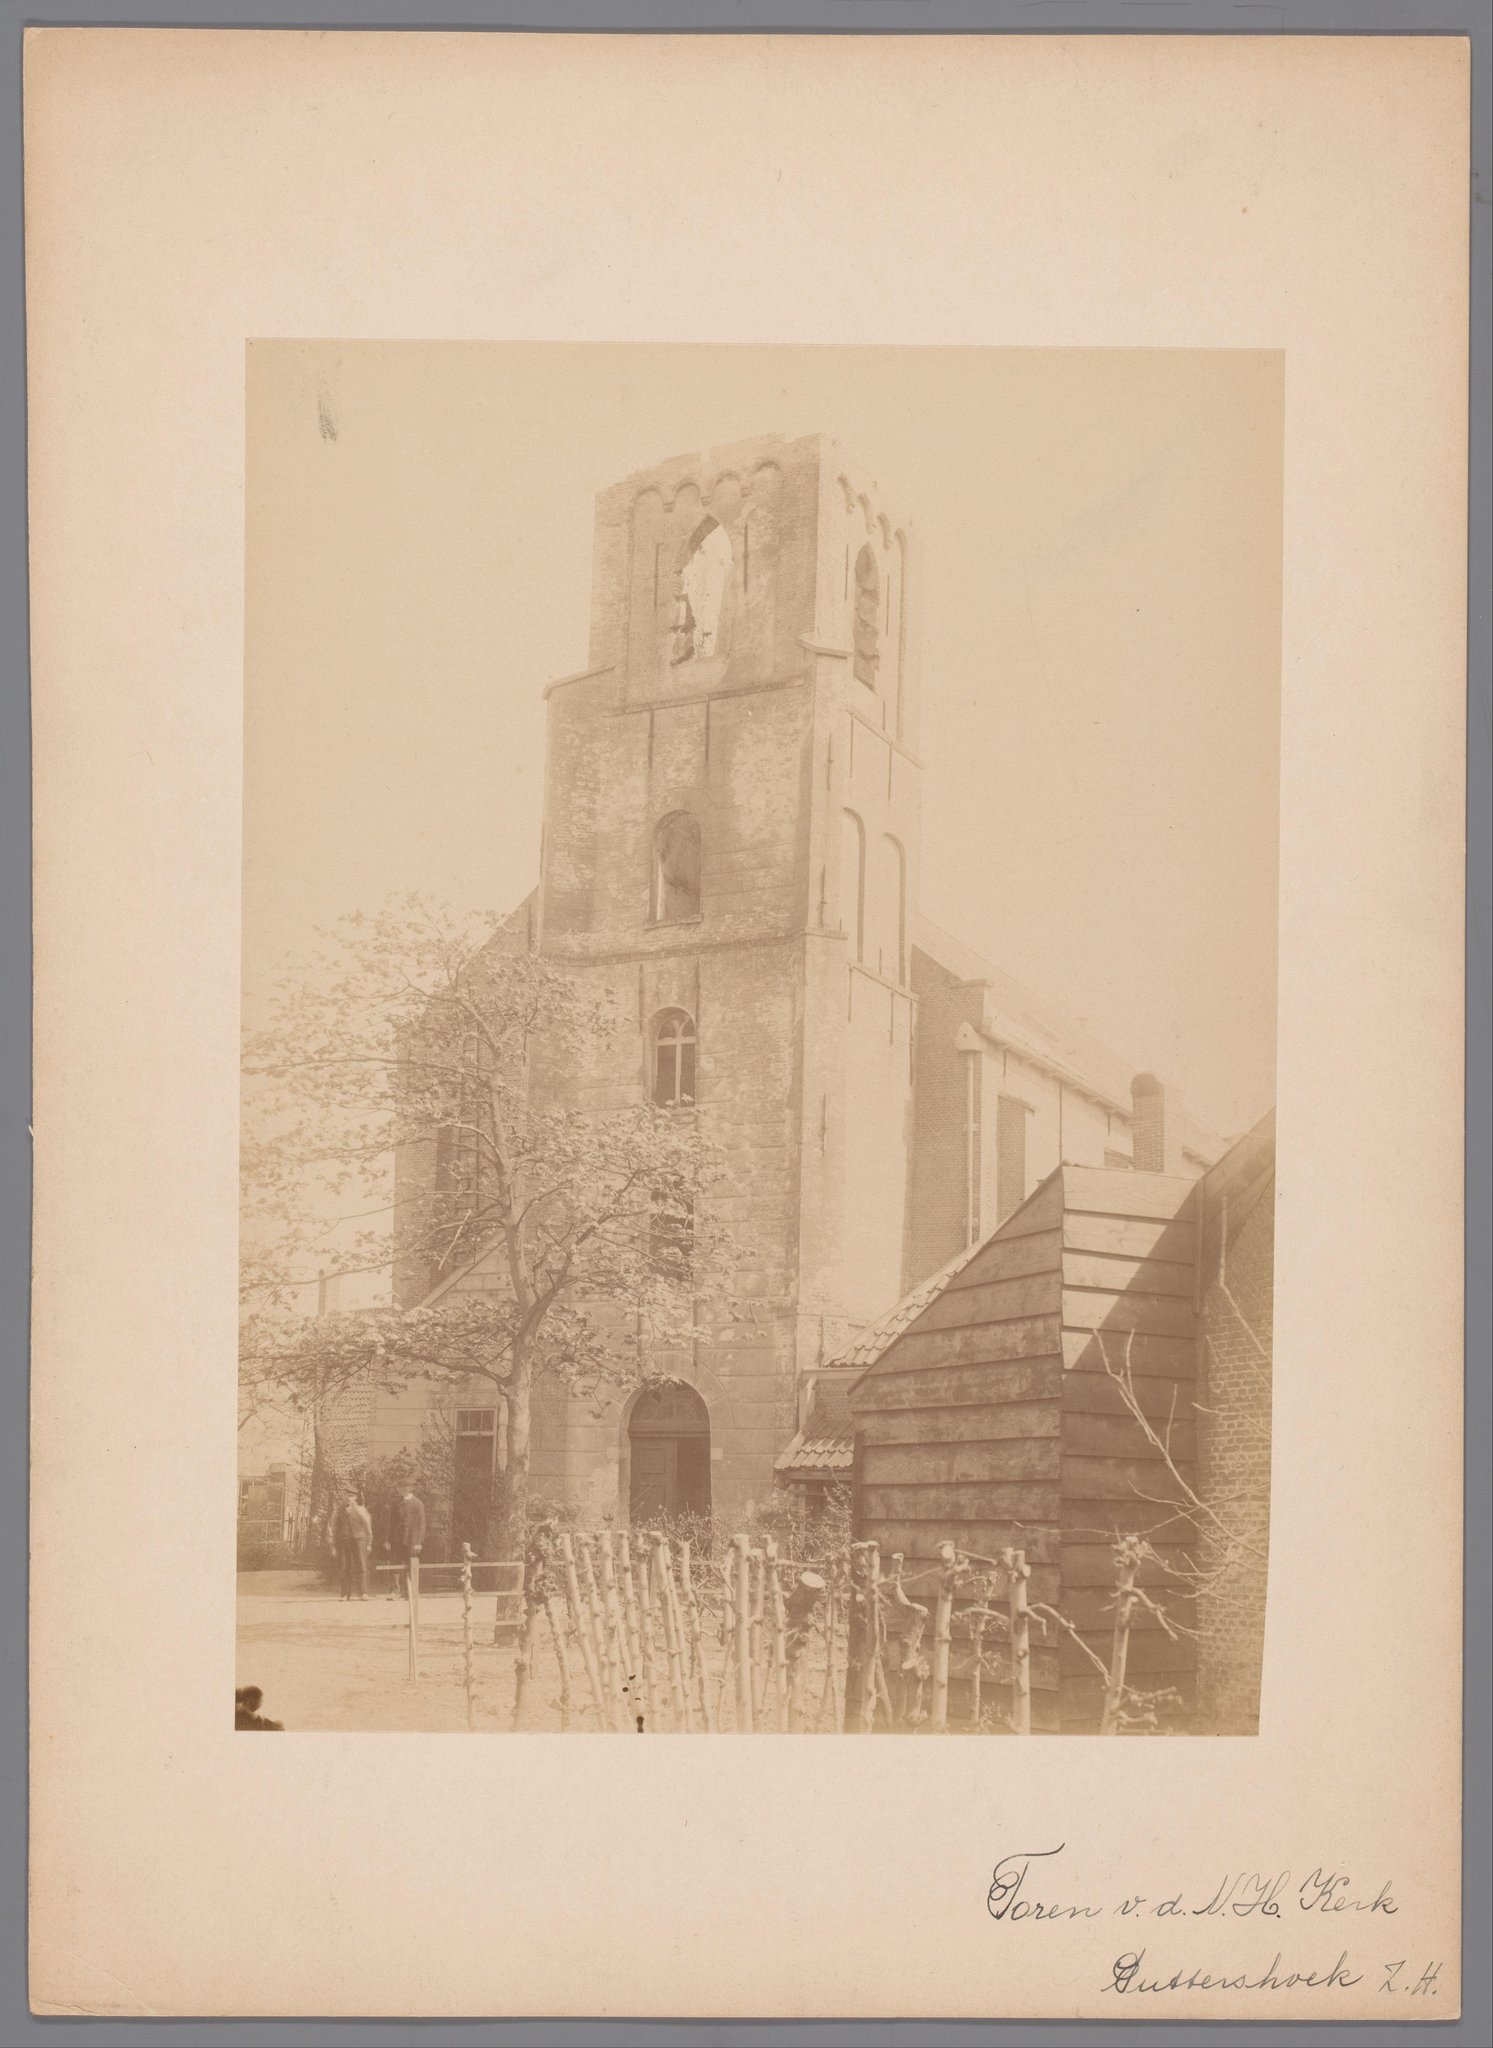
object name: photograph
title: Toren van de Hervormde Kerk te Puttershoek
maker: anoniem (monumentenzorg)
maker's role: fotograaf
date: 1889-1904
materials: cardboard, photographic support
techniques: albumen print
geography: poortugaal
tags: parts of church exterior and annexes: tower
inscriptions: annotation: ‘Putershoek Z.H./ Toren v/d N.H. kerk’, annotation: ‘Toren v.d. N.H. Kerk/ Puttershoek Z.H.’